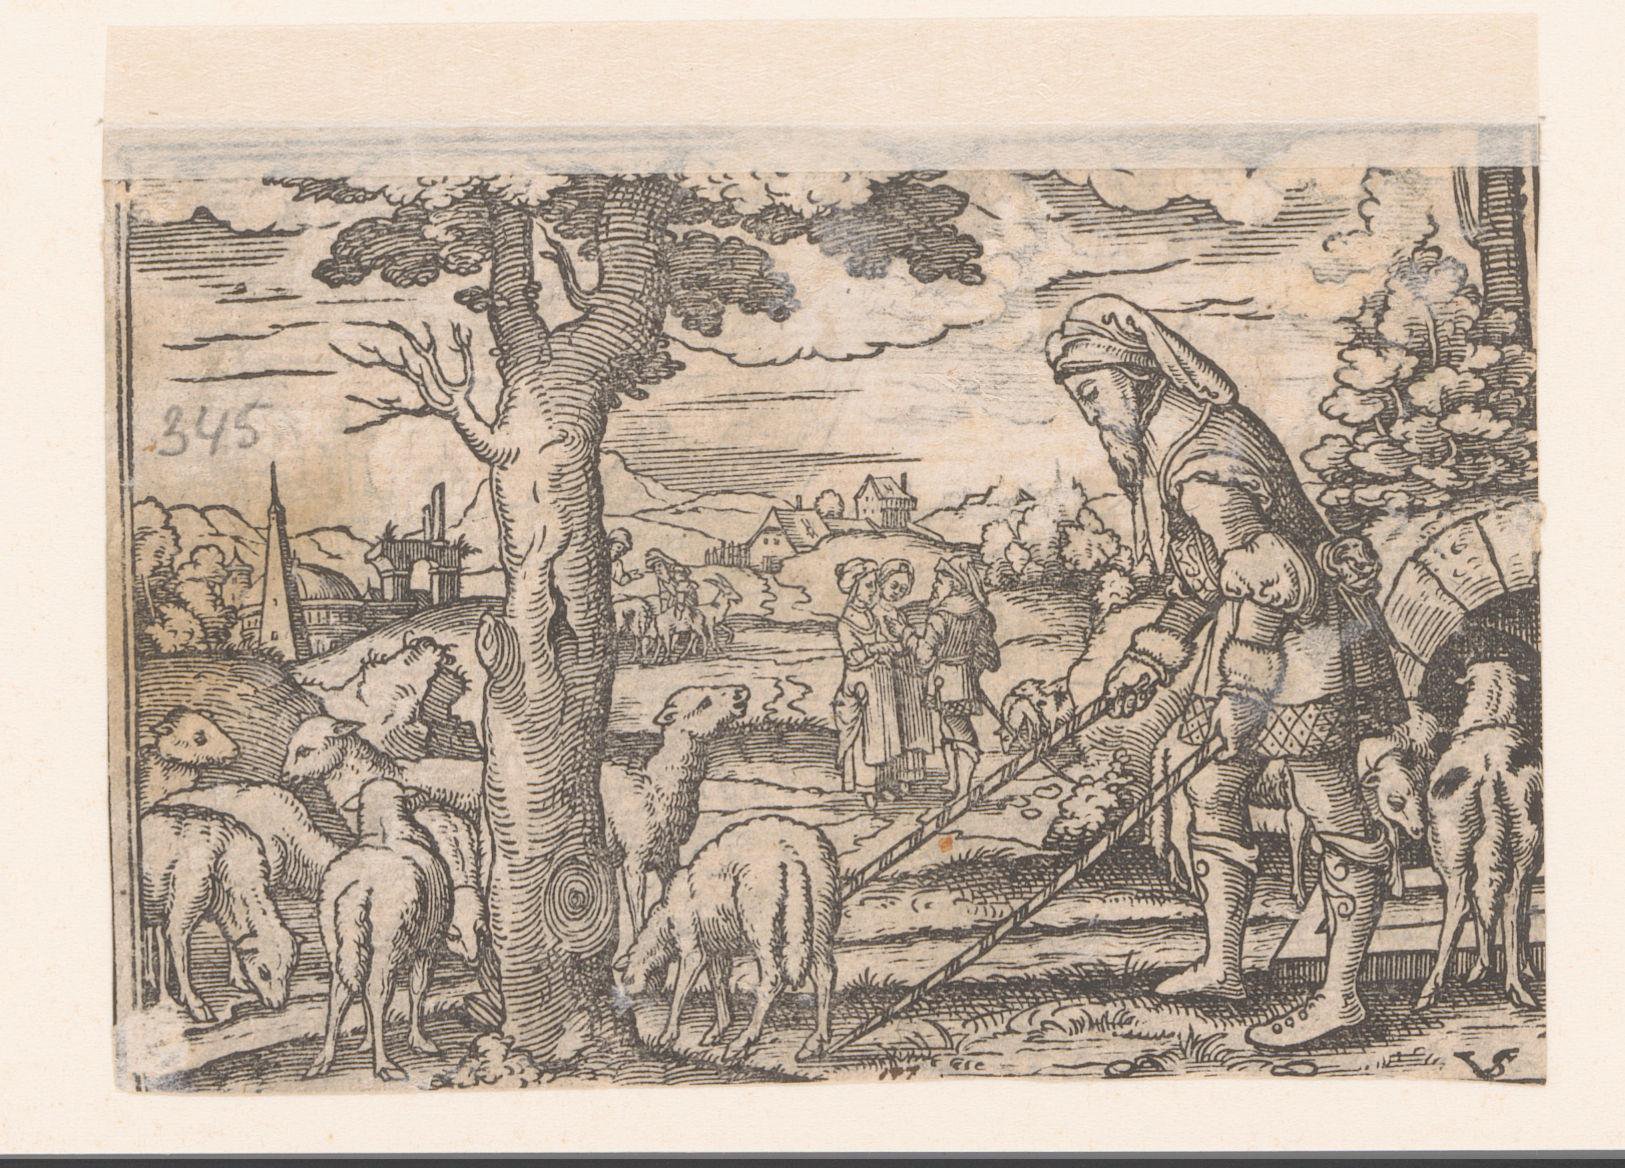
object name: book illustration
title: Jakob hoedt de kudde van Laban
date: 1565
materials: paper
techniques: woodcut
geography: frankfurt am main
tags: jacob works as a herdsman for seven years in exchange for rachel, landscape with ruins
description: Jakob en Rachel met de kudde van Laban in een landschap. In ruil voor de hand van Rachel verplicht Jakob zich om zeven jaar als herder te dienen voor Laban.